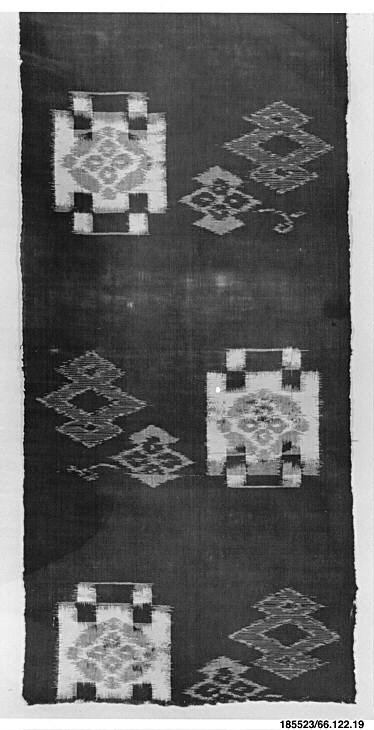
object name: piece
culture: japanese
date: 1801-1900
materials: cotton